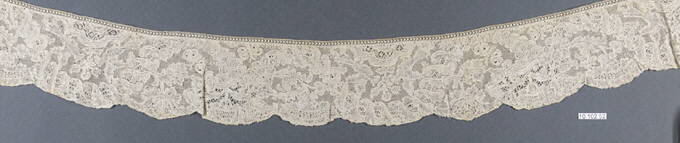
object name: border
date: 1701-1800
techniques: lace